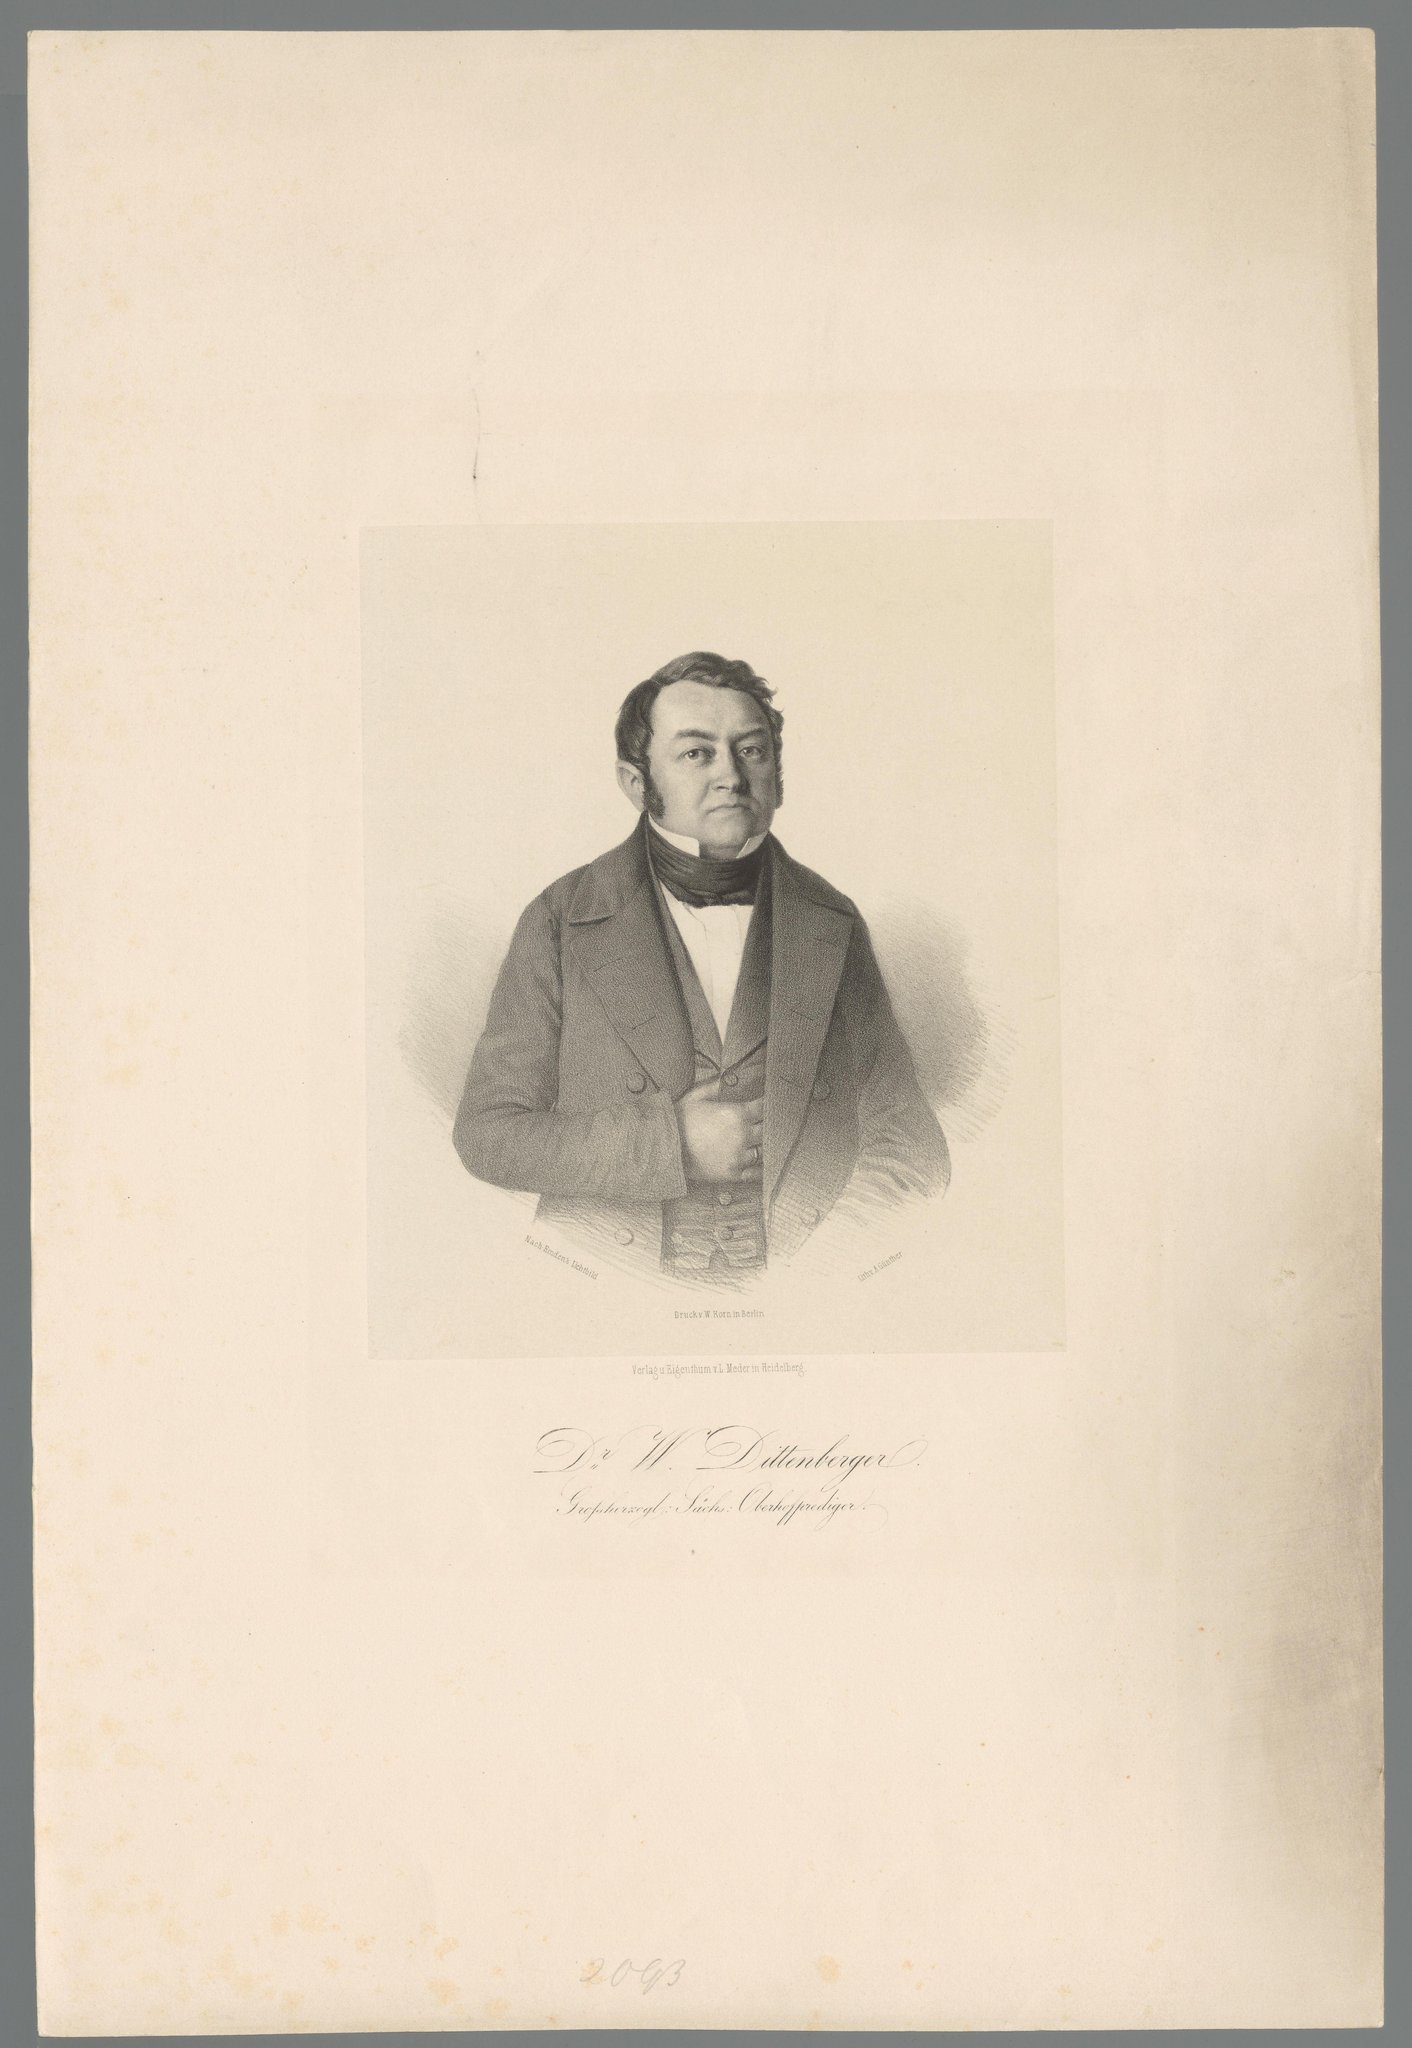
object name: print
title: Dr. W. Dittenberger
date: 1840-1860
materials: paper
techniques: lithograph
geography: heidelberg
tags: adult man, historical persons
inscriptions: collector's mark: Lugt 2228